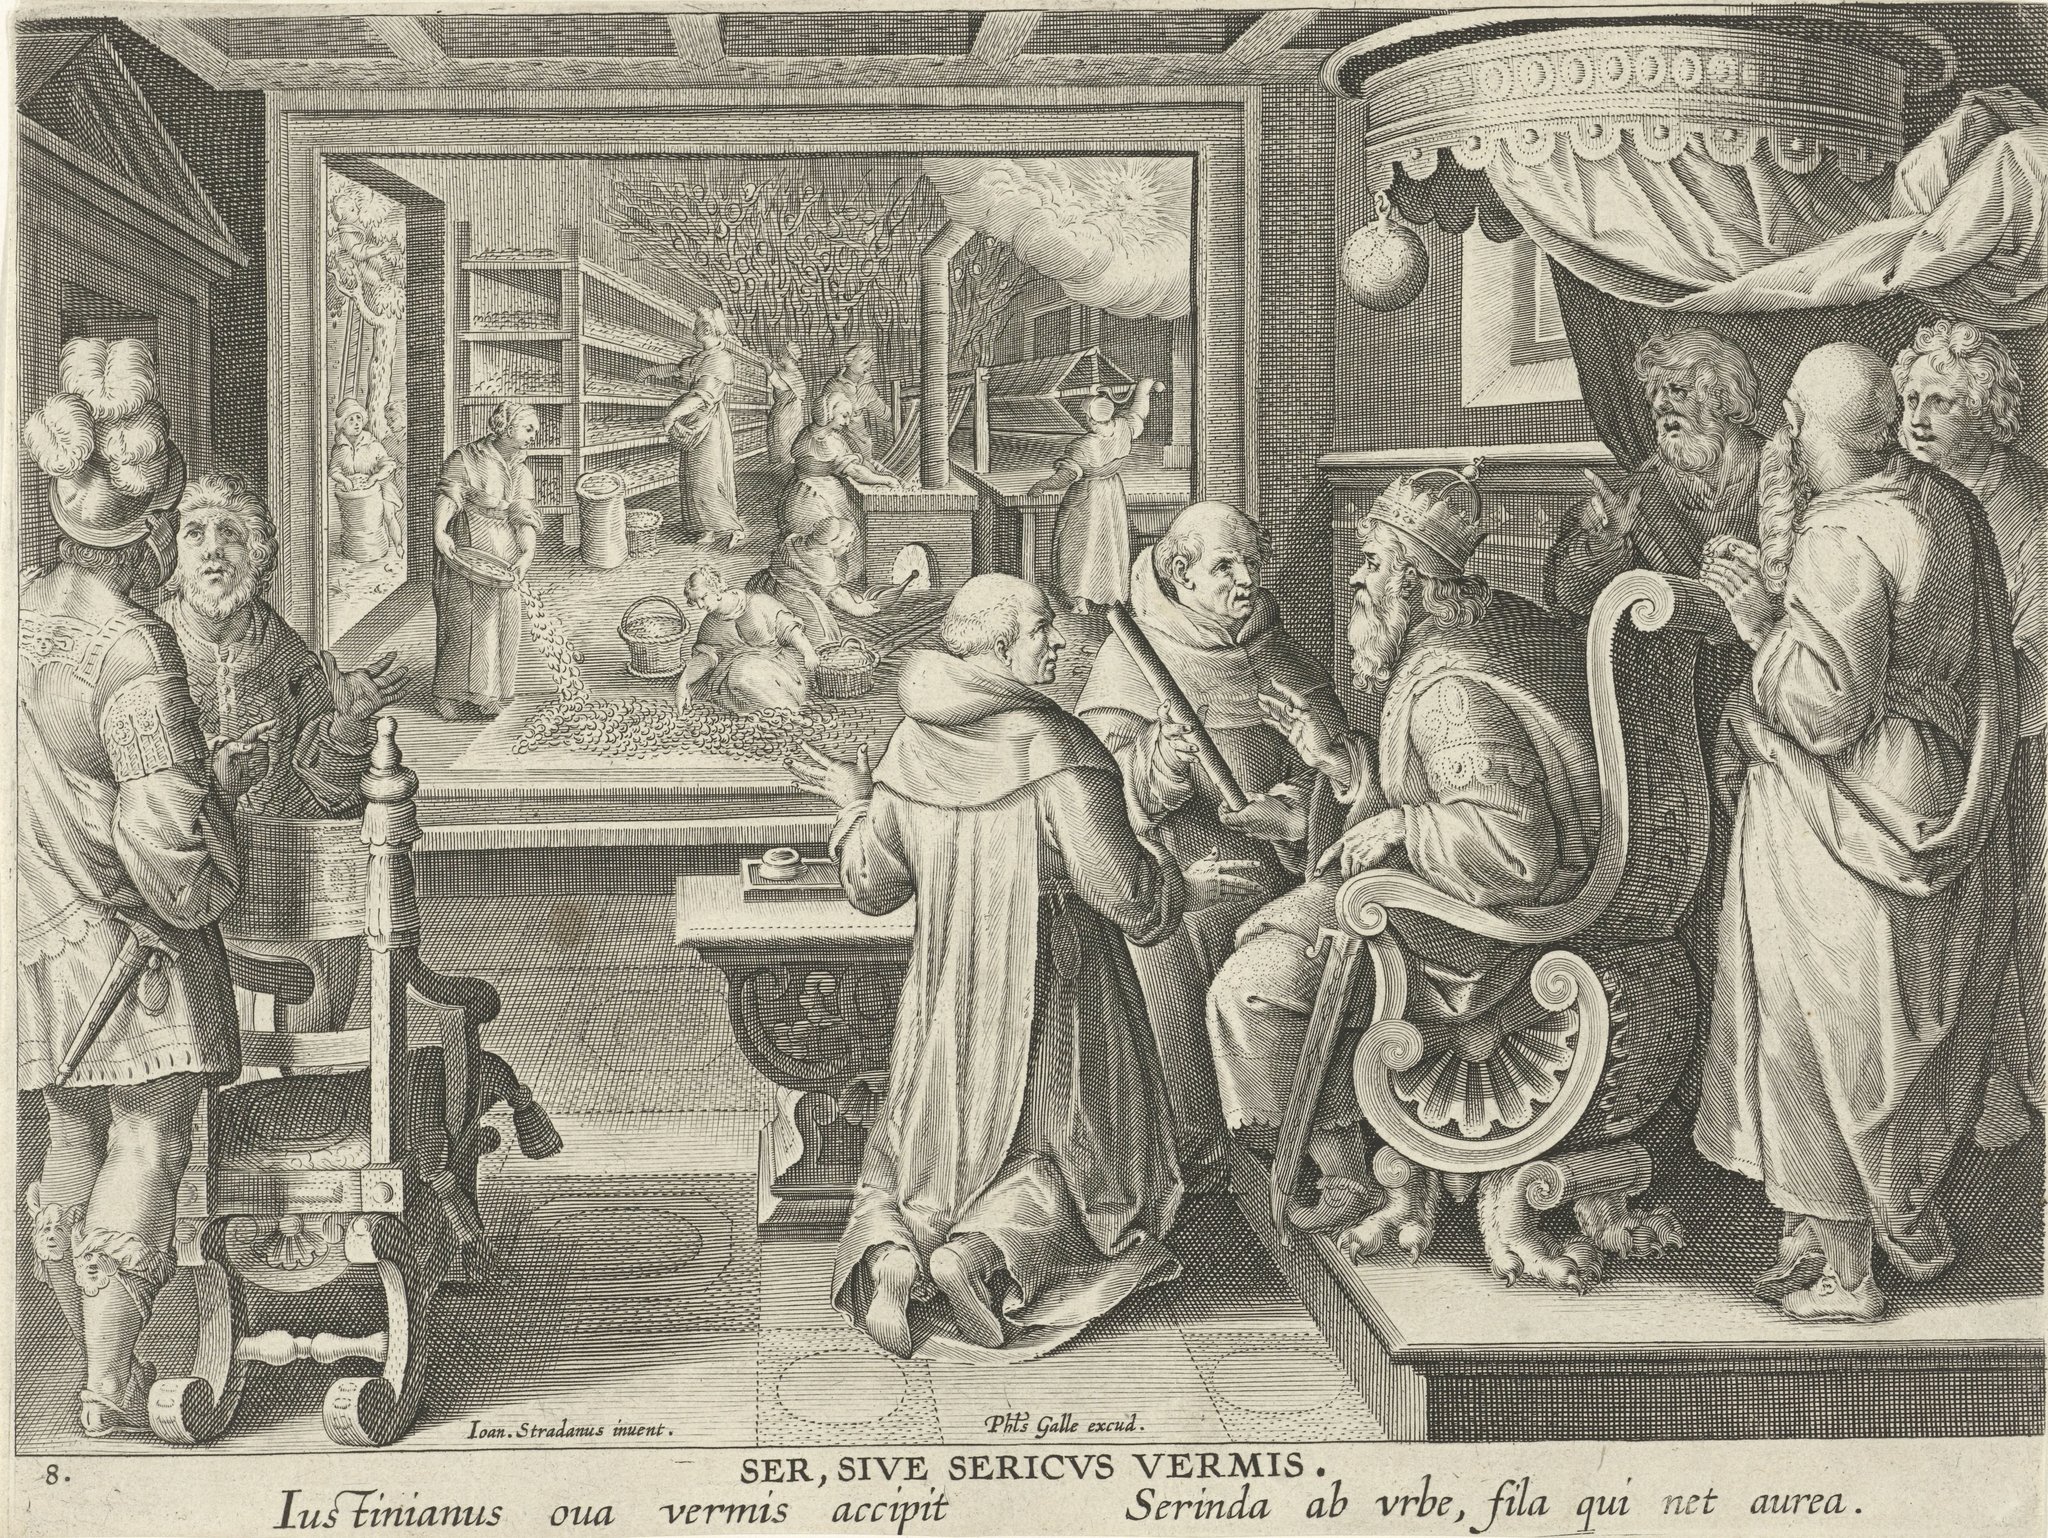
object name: print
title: Nieuwe uitvindingen en ontdekkingen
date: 1589-1593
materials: paper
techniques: engraving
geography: antwerp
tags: invention, discovery ~ science and technology, silkworm, workshop (+ materials processed ~ crafts, industries, agriculture), silk (material ~ textile industry)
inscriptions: collector's mark: Lugt 2228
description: Keizer Justinianus zit op een troon en ontvangt uit de handen van twee monniken een bamboestok met de eieren van de zijdeworm. De monniken hadden deze eieren uit China gesmokkeld en daarmee was het Chinese monopolie op zijde gebroken. Op de achtergrond alle fazen van de zijdebewerking. Eerst worden de moerbeibladeren geplukt. Vervolgens worden de zijdewormen op de bladeren losgelaten. Daarna wordt de zijde geoogst en weven vrouwen er textiel van. De prent heeft een Latijns onderschrift en maakt deel uit van een negentiendelige serie over nieuwe uitvindingen en ontdekkingen.